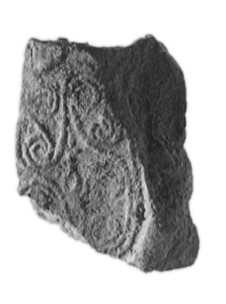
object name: sealing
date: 2030-1640 BCE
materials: clay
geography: egypt